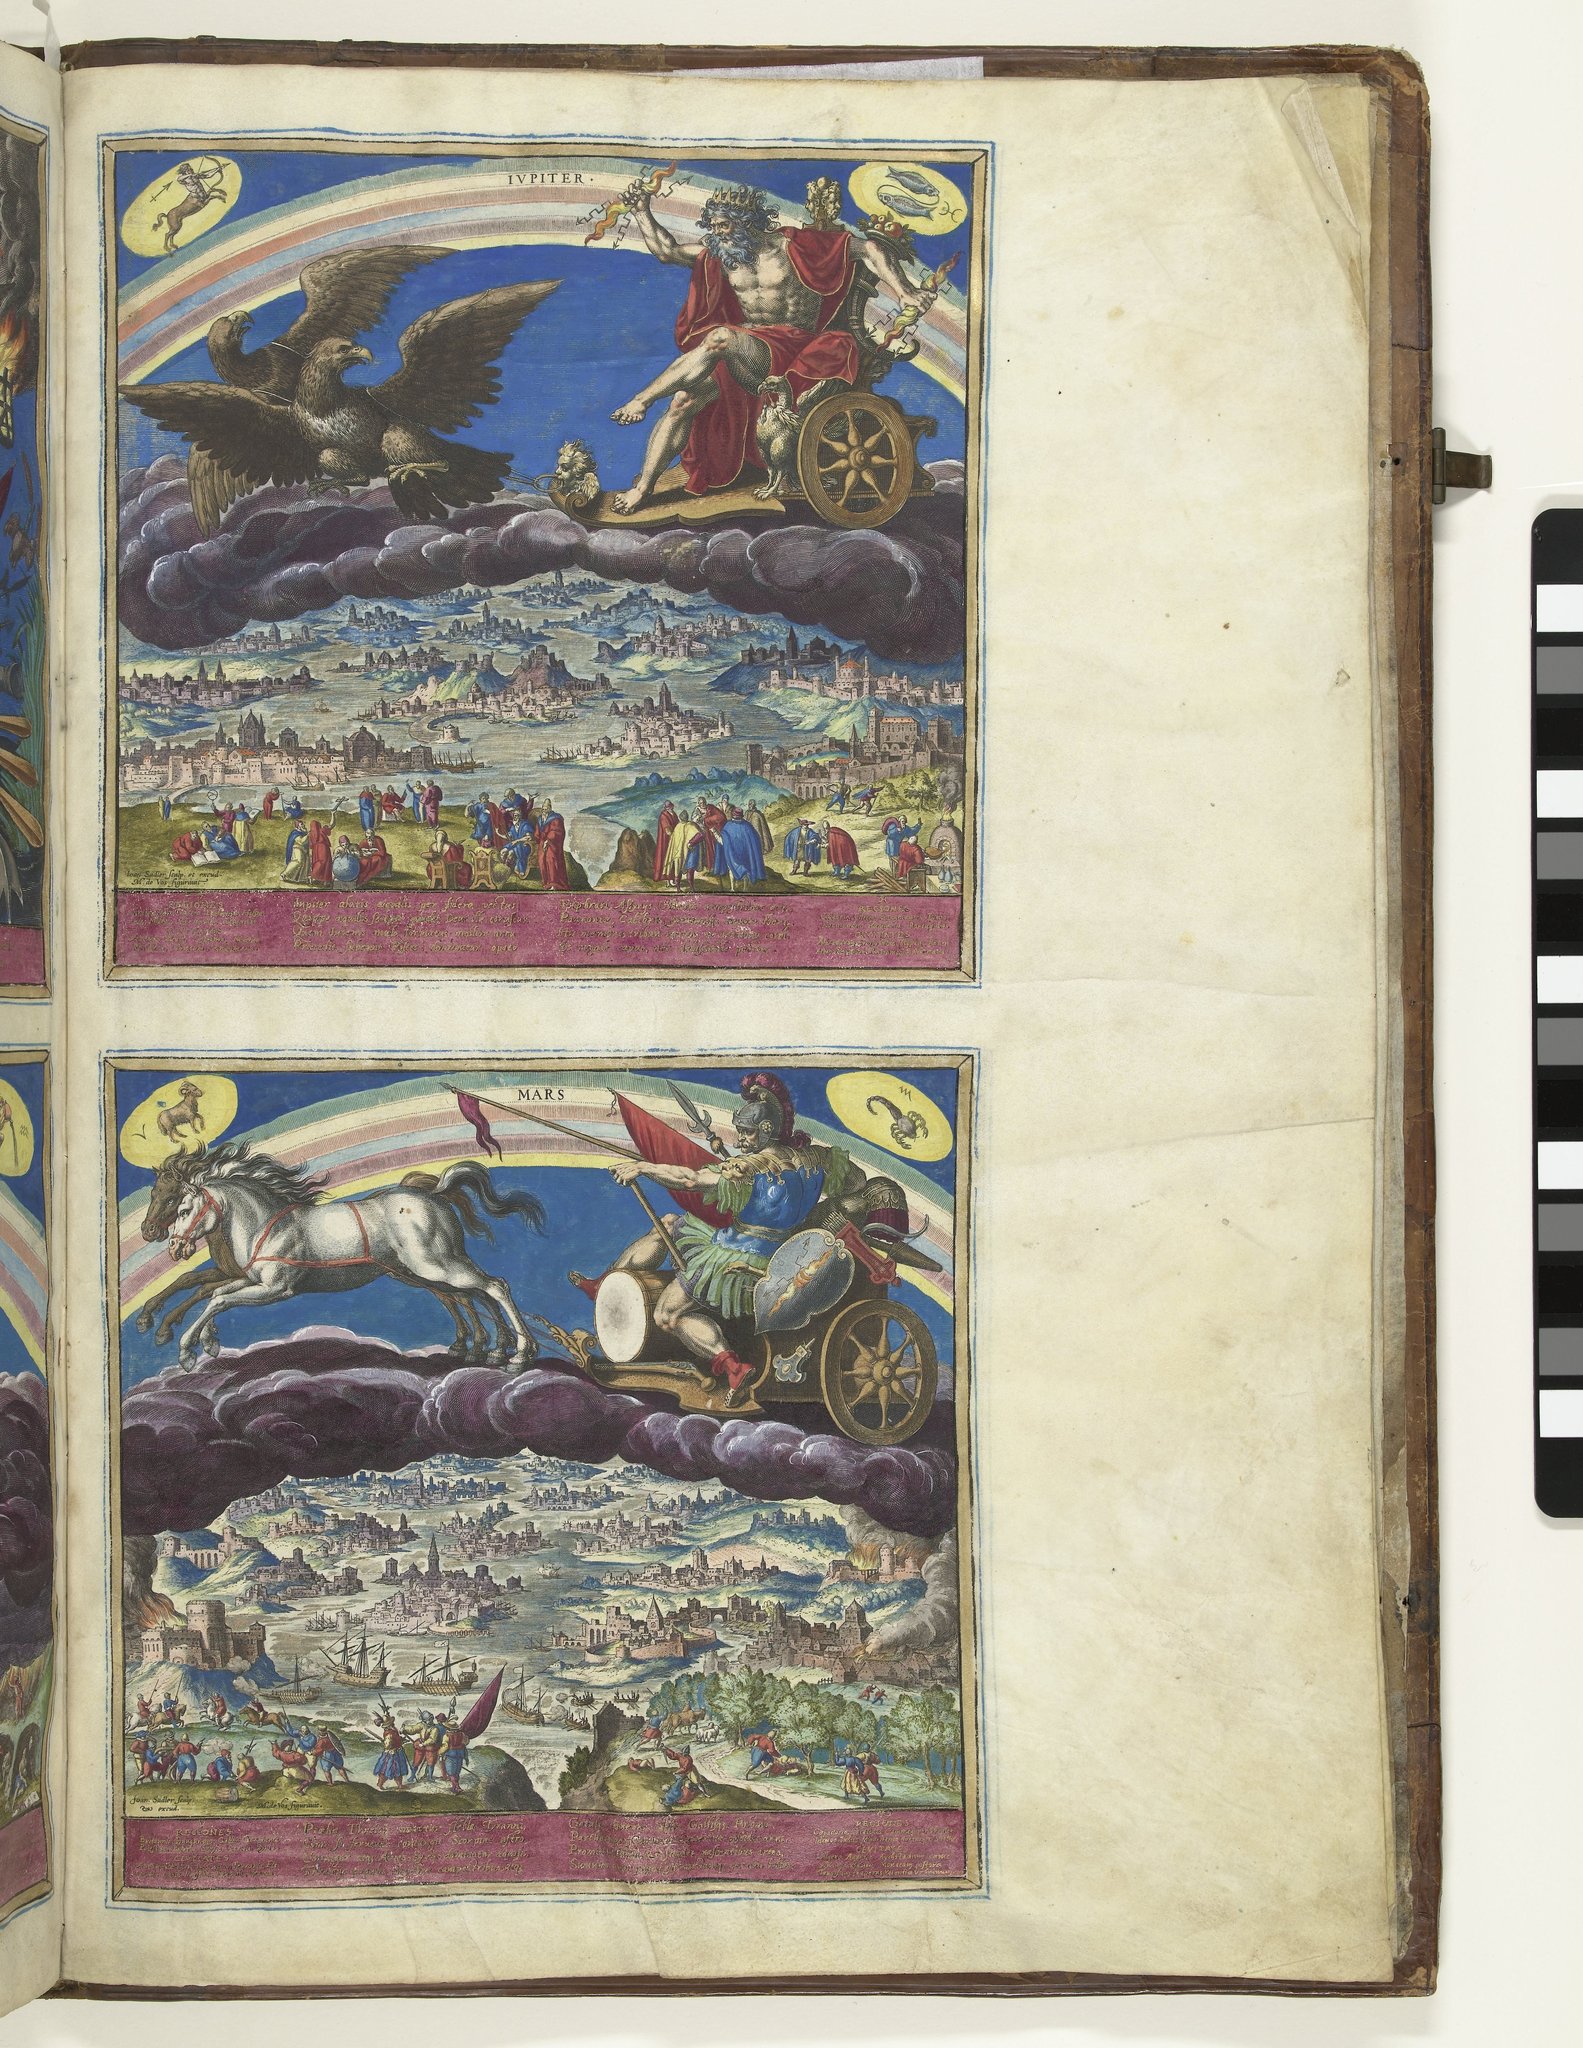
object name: album leaf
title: De zeven planeten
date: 1585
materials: paper, parchment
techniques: engraving, hand coloring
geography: antwerp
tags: military service, (story of) mars (ares), siege, position war, mars and his children ('planetenkinder') ~ aries and scorpio, chariot, triumphal car, landscapes with waters, waterscapes, seascapes (in the temperate zone), fighting, italy, germany, spain, england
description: De god Mars op zijn zegewagen, getrokken door twee paarden, rijdend op de wolken. Linksboven het sterrenbeeld Ram, rechtsboven het sterrenbeeld Kreeft. Onderaan een rivierlandschap met vechtende soldaten en brandende steden. Onder de voorstelling een lofdicht in het Latijn over de invloed van planeet Jupiter op de streken van Europa (Engeland, Italië, Duitsland, Spanje). Deze prent maakt deel uit van een album.